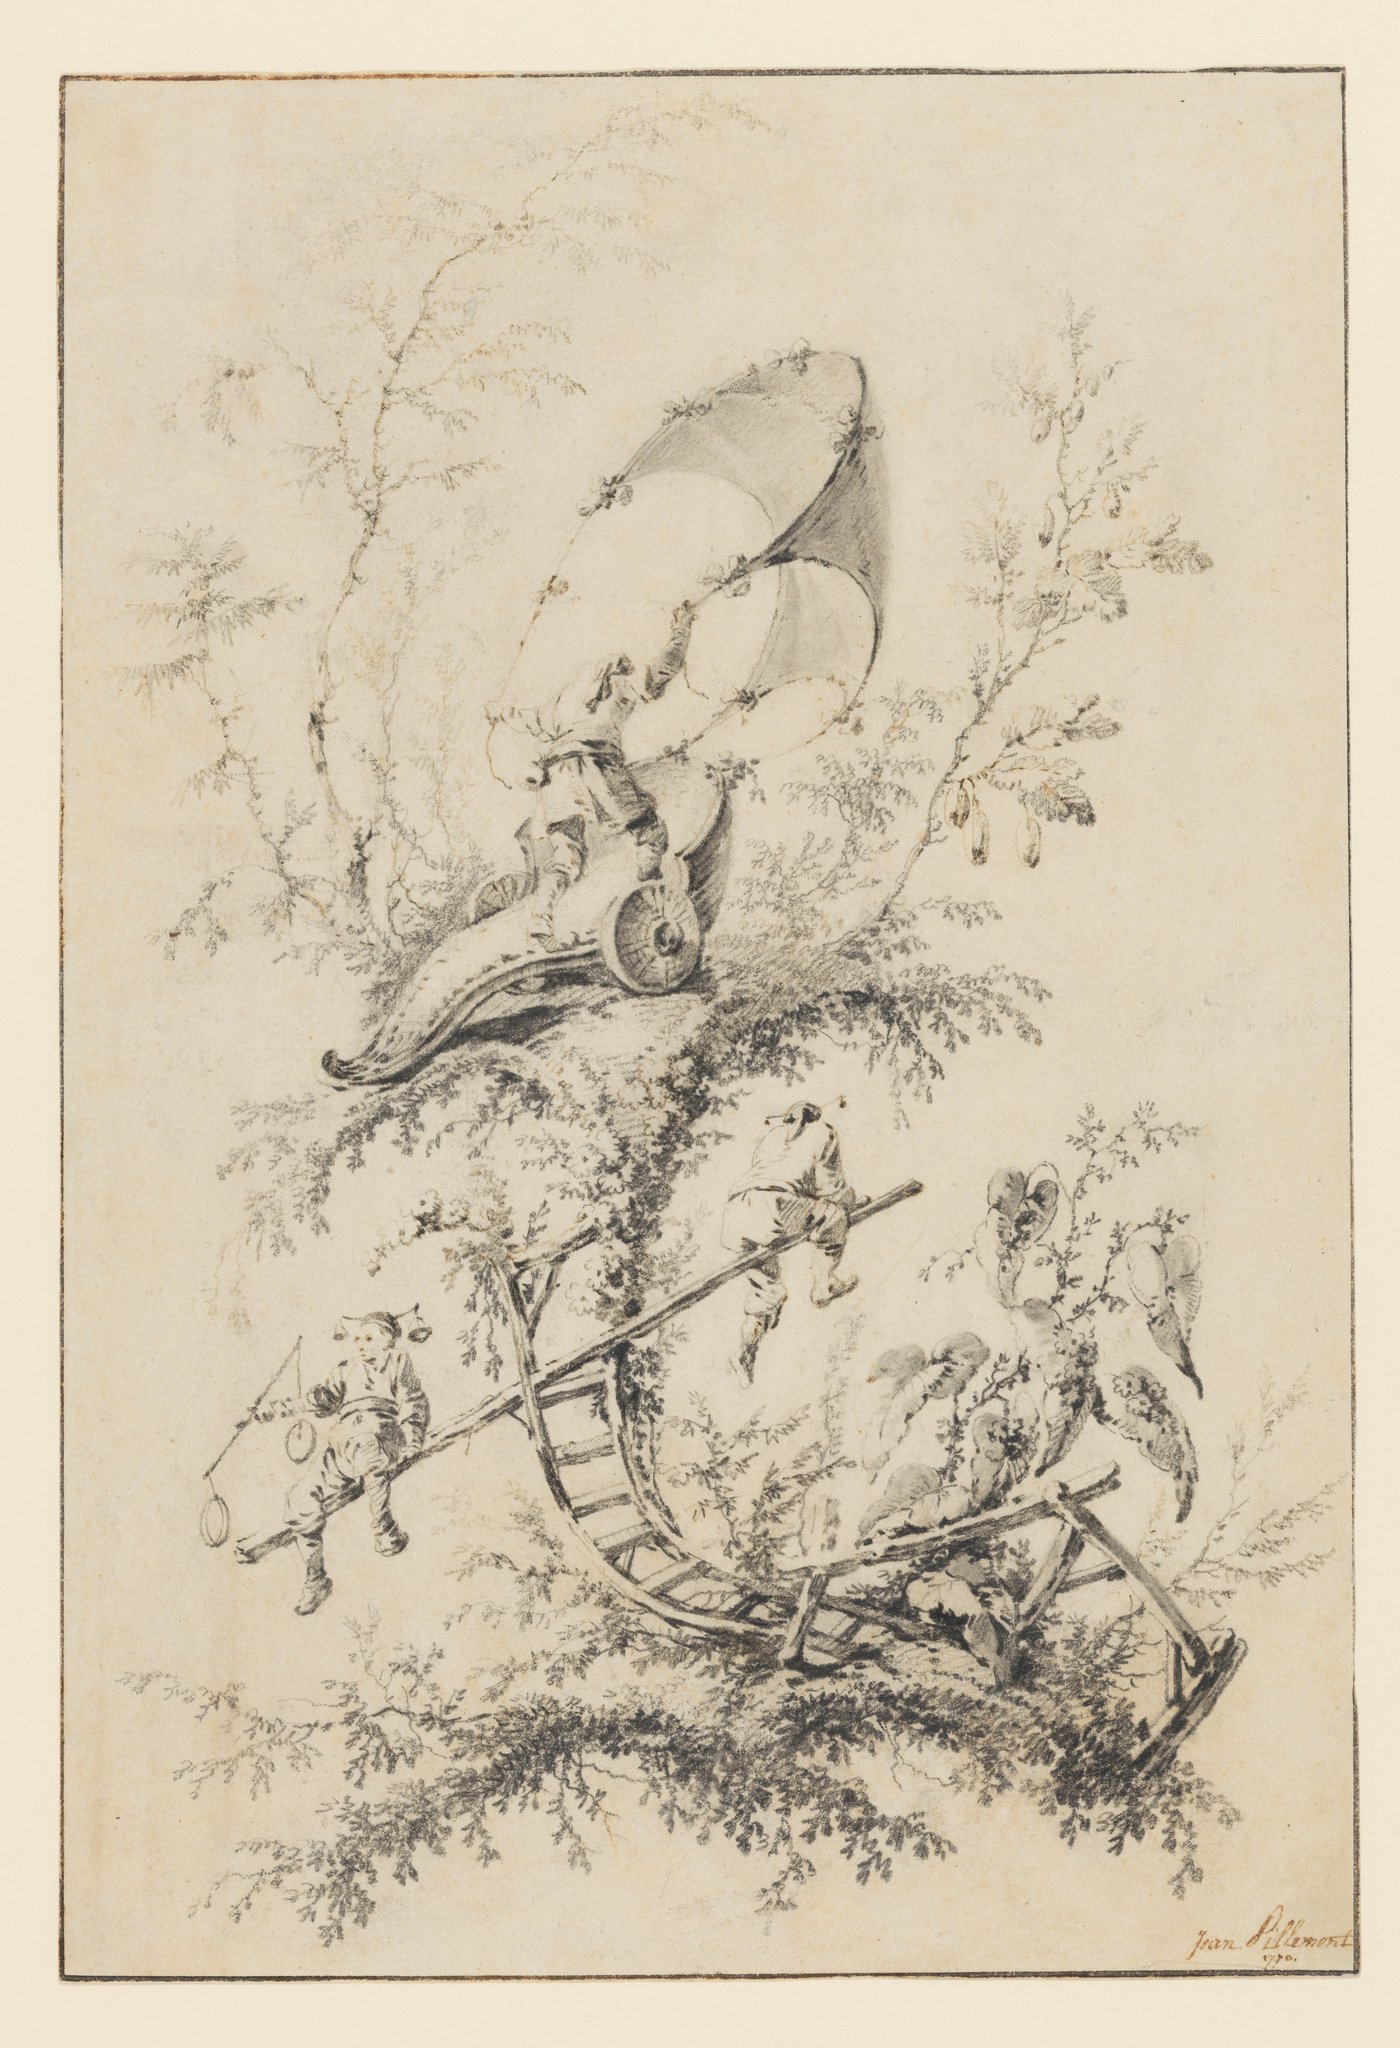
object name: ornament architecture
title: Design for the "Cahier de Balançoires Chinoises"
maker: jean pillement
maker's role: artist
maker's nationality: french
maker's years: 1728-1808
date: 1770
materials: chalk, ink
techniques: pen, stumping